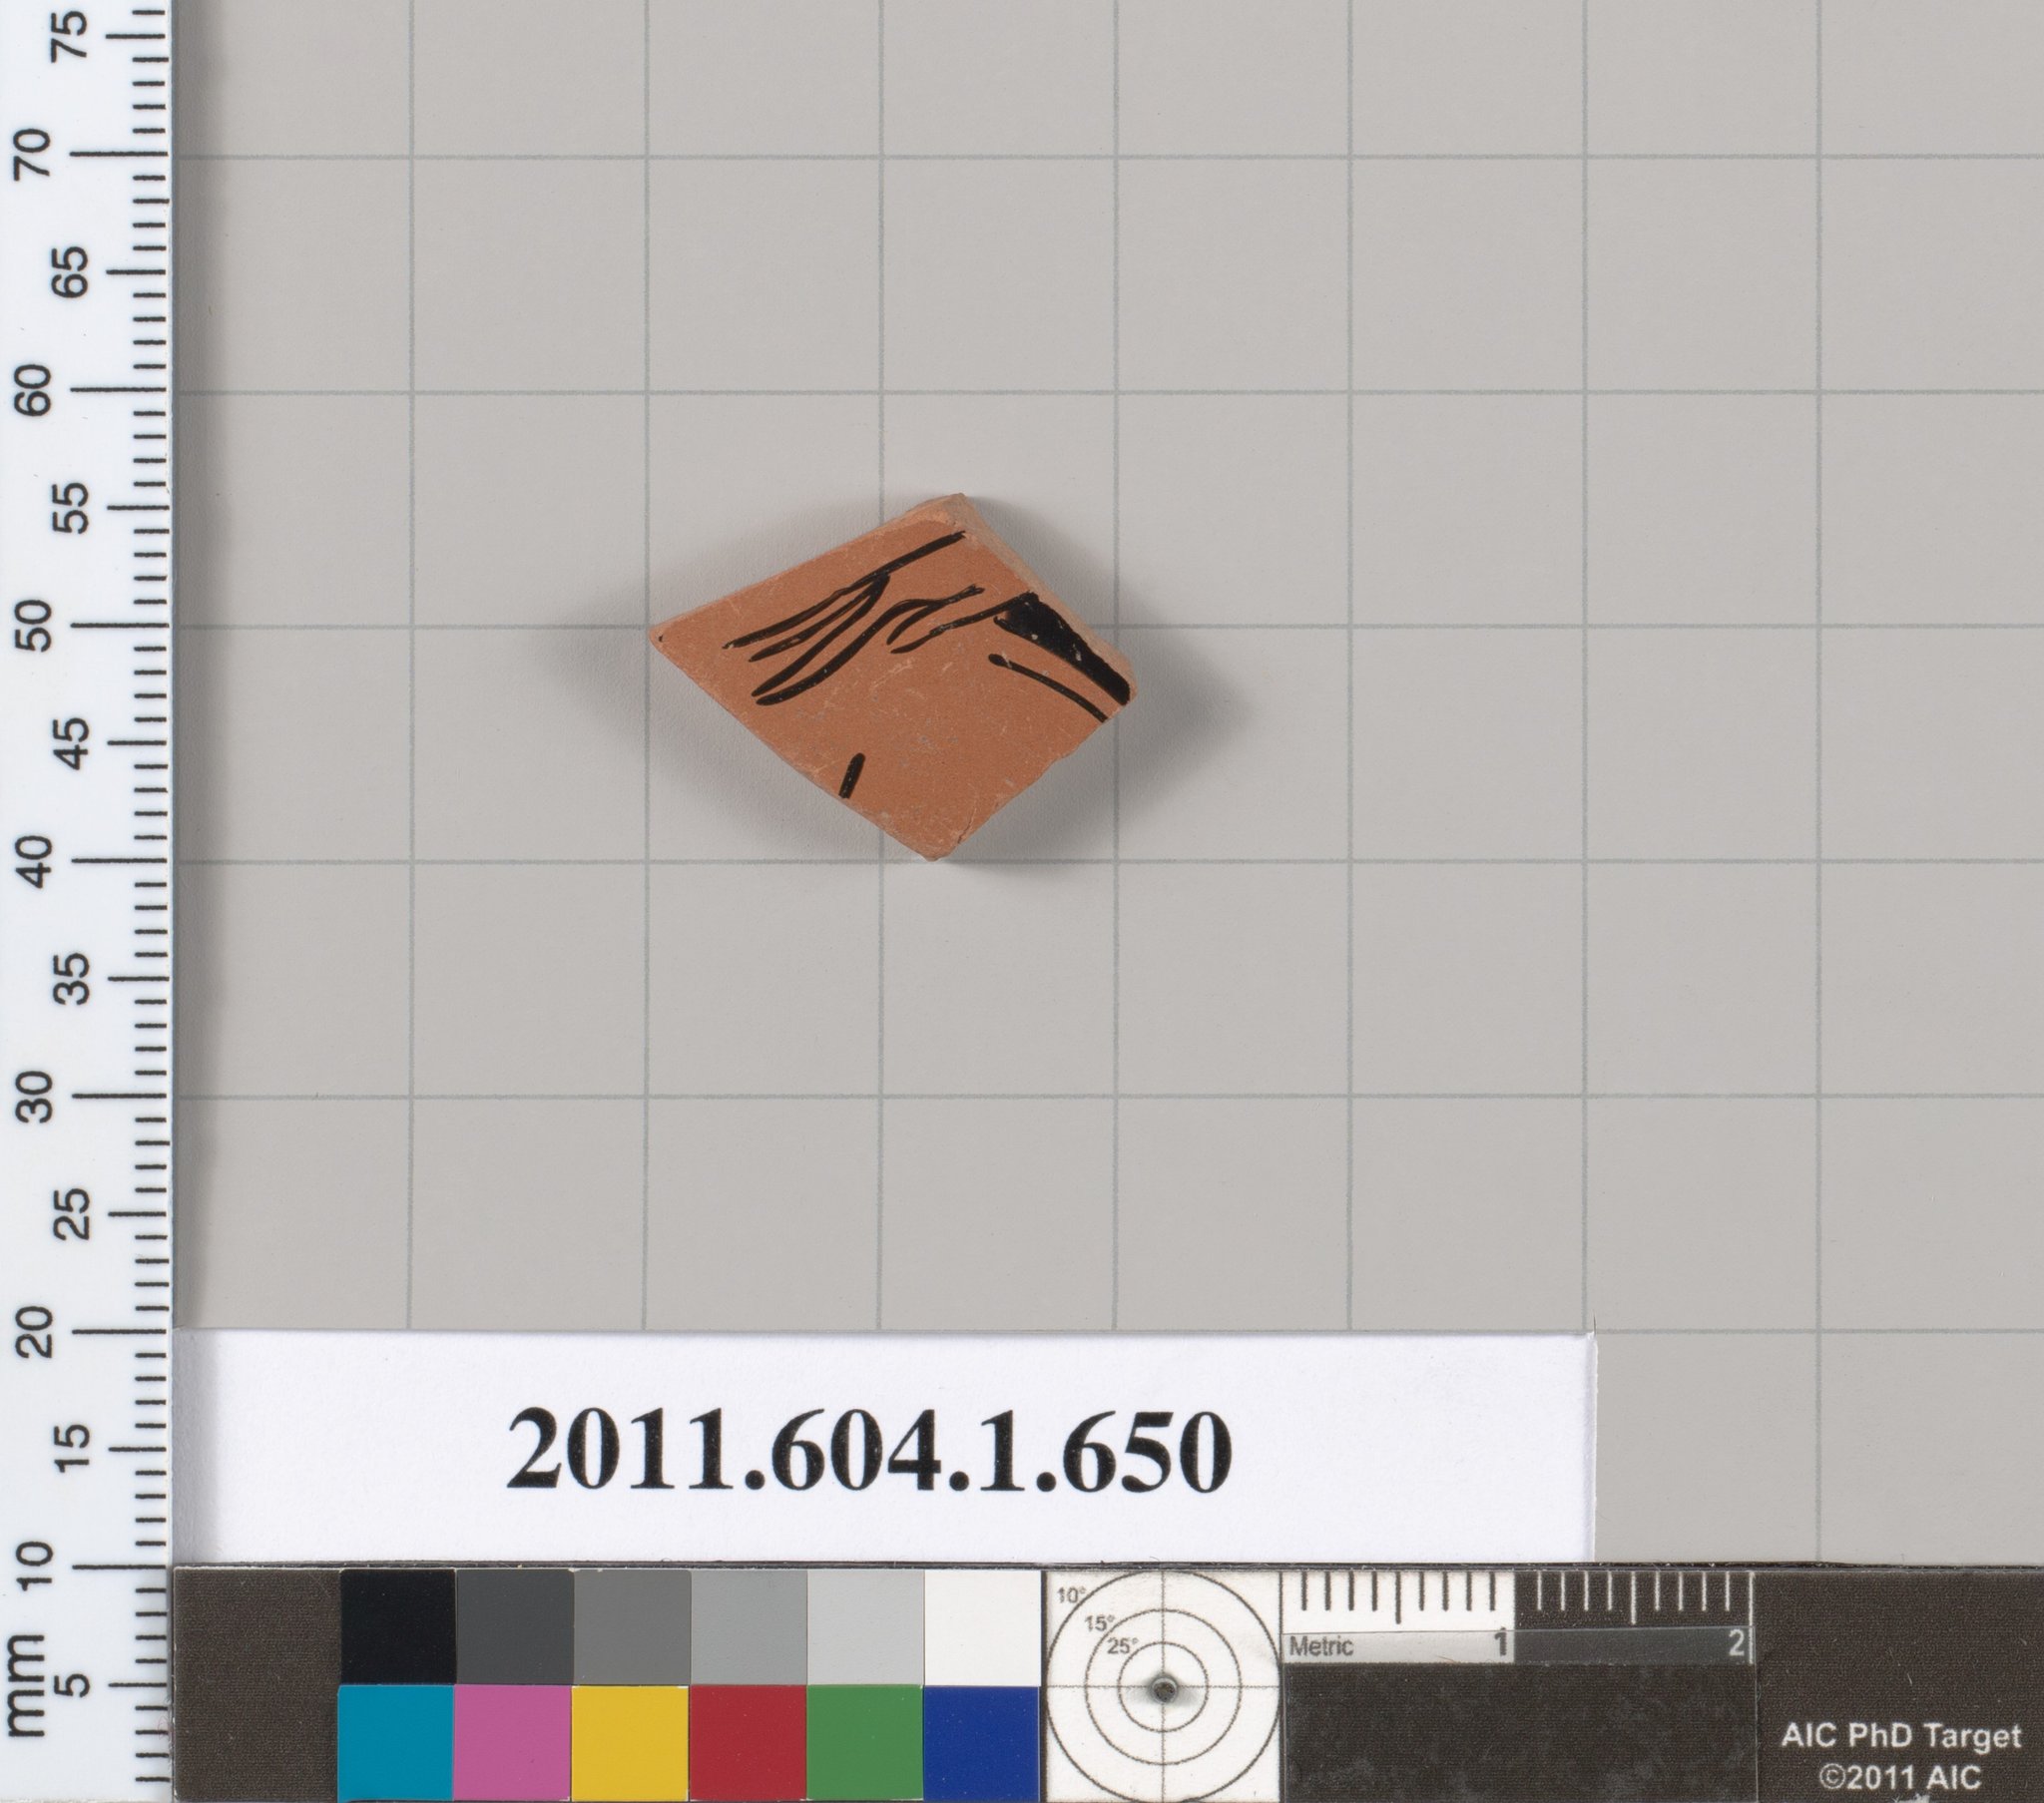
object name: kylix fragment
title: Terracotta fragment of a kylix (drinking cup)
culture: greek, attic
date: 475-451 BCE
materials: terracotta